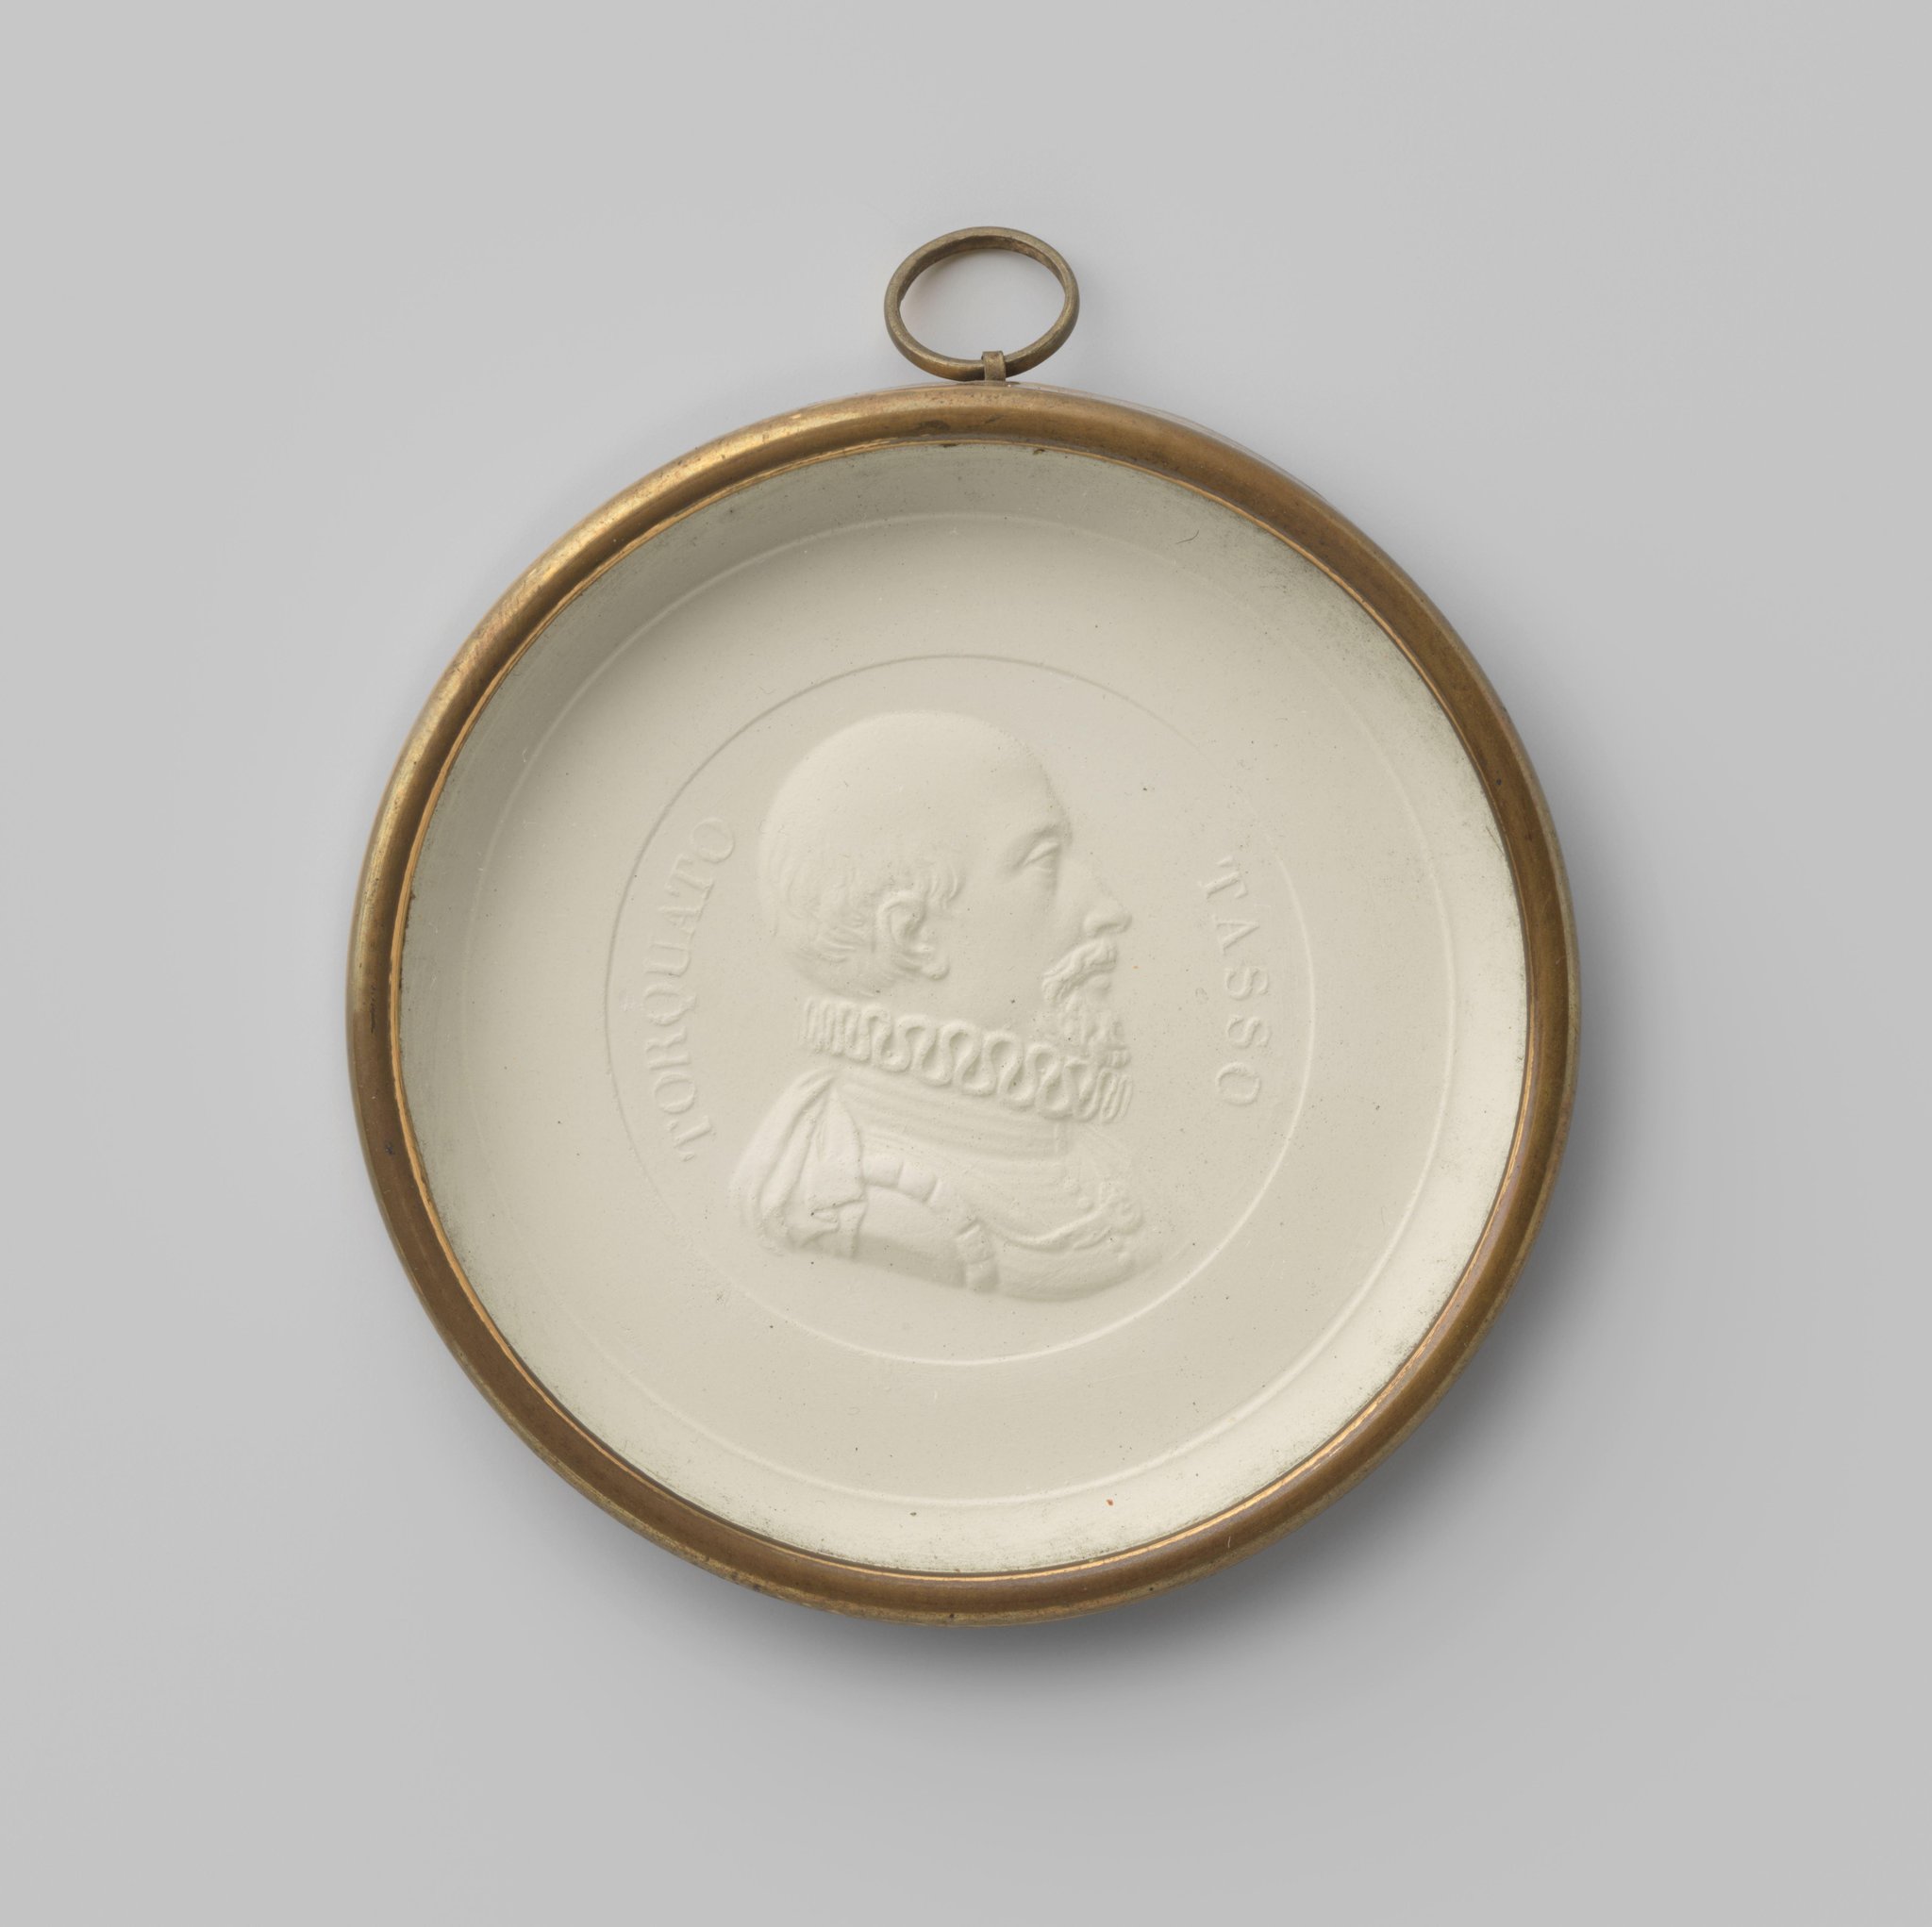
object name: locket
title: Torquato Tassa, Italiaans dichter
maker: gottfried eichler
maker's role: draughtsman, painter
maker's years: 1677-1757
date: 1687-1757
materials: brass, glass, gypsum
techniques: casting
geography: berlin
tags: rome, torquato tasso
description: Eenzijdig gipsen medaillon in messing ring achter glas aan draagoog en draagring. Voorzijde: borststuk man naar rechts binnen omschrift. Keerzijde: etiket met opschrift.